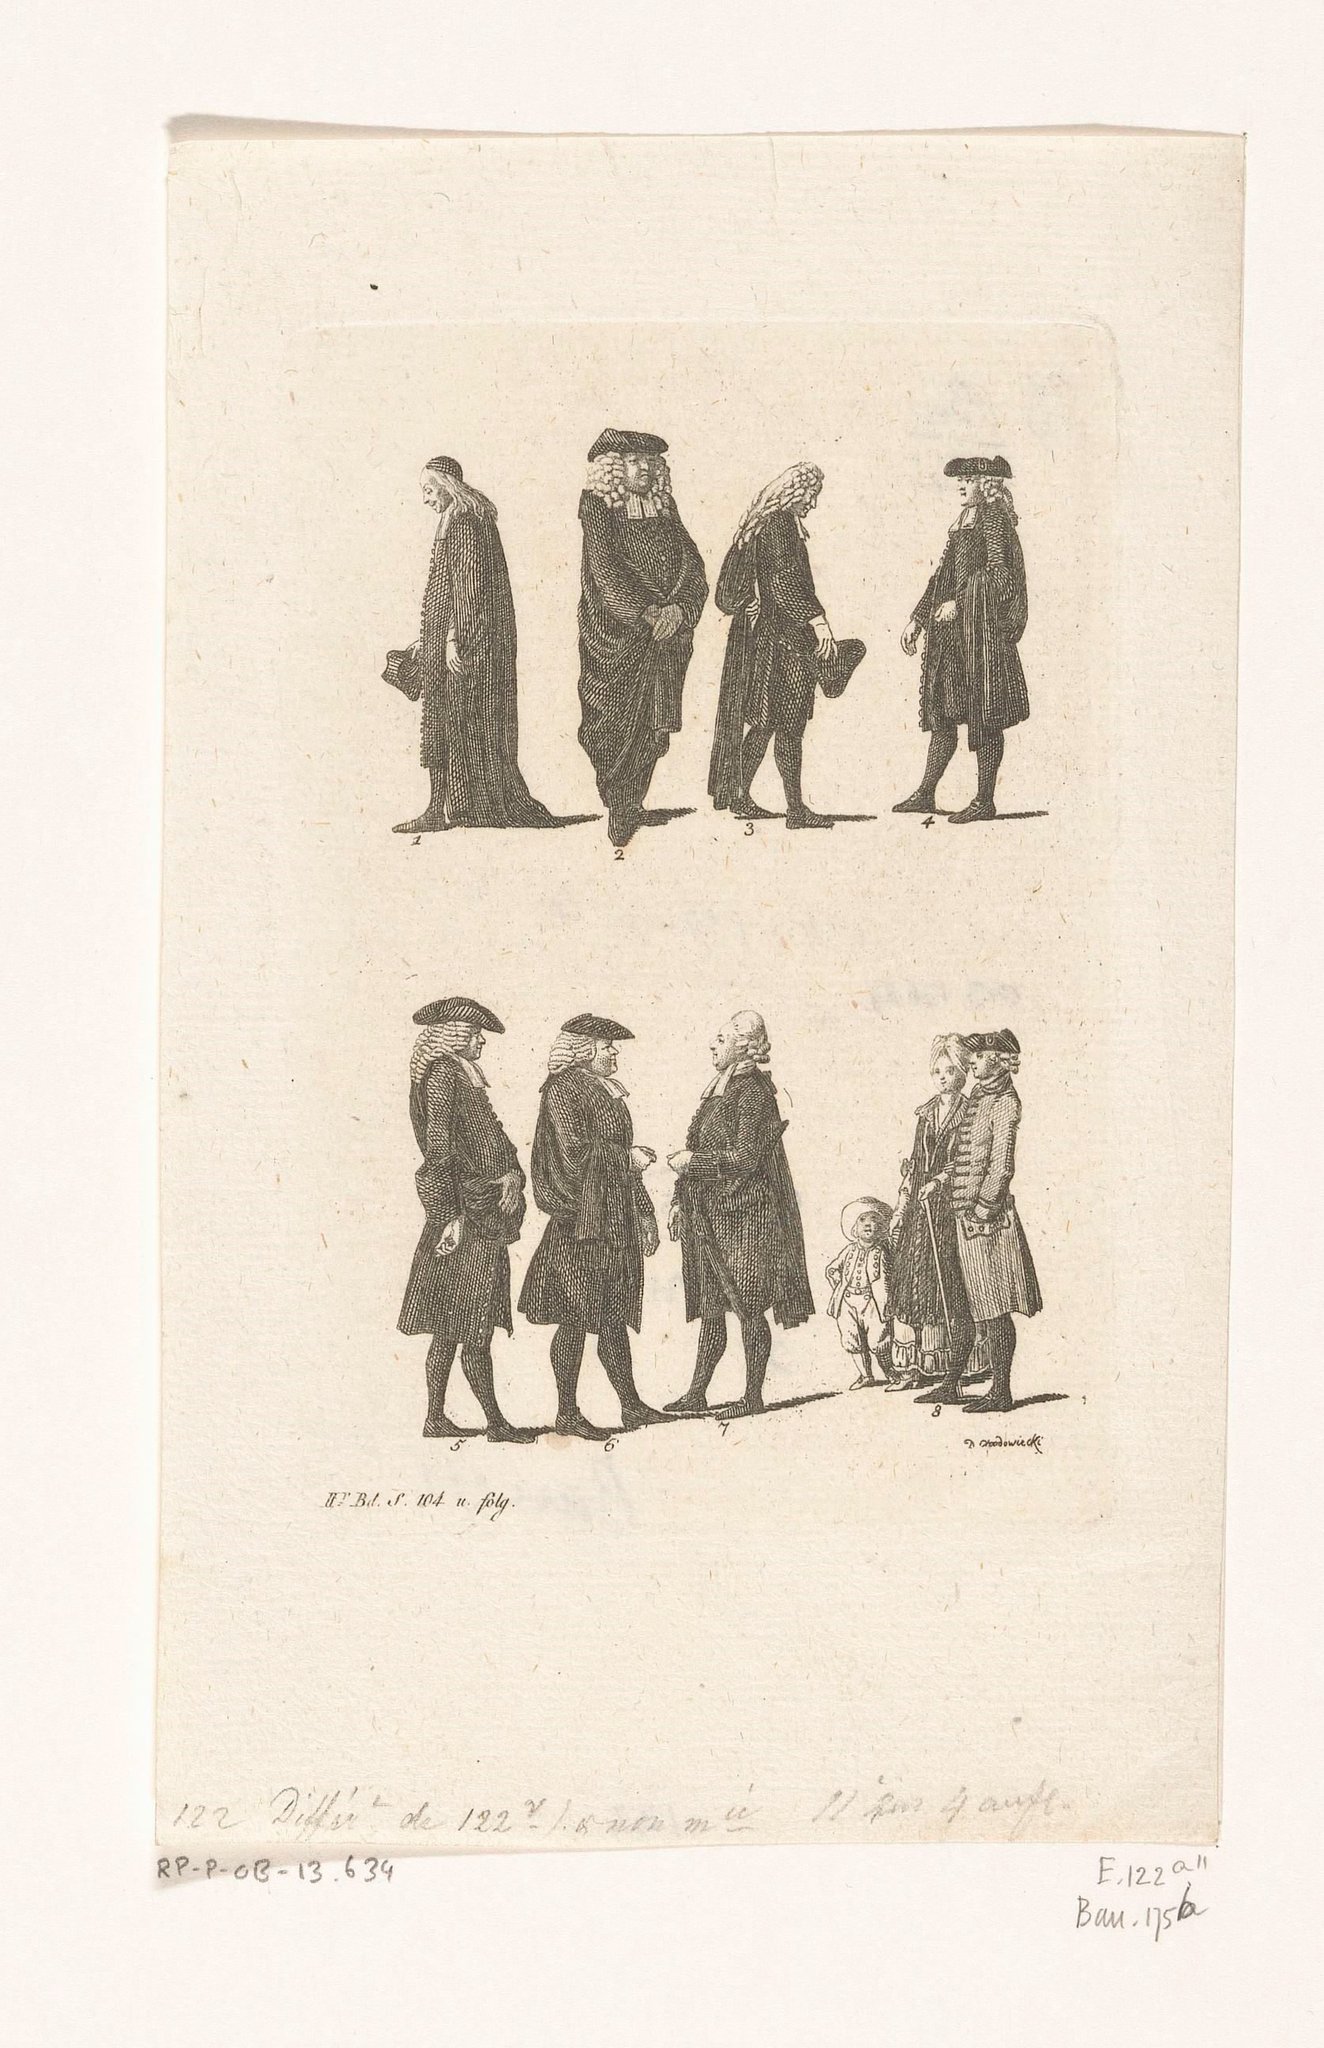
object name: print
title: Predikanten in ambtskleding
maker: daniel nikolaus chodowiecki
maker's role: draughtsman, print maker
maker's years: 1726-1801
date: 1775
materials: paper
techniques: etching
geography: berlin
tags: berlin, friedrich nicolai, literature, functionaries and dignitaries ~ episcopal protestant churches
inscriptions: collector's mark: Lugt 2228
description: Deze scène behoort tot een serie prenten die het verhaal van Sebaldus Nothanker door Friedrich Nicolai illustreren. De tweede staat van deze prent is gebruikt in: [Nicolai Friedrich]. Das Leben und die Meinungen des Herrn Magister Sebaldus Nothanker. Berlijn en Stettin: Friedrich Nicolai, 1776 [vierde editie], dl. 2.